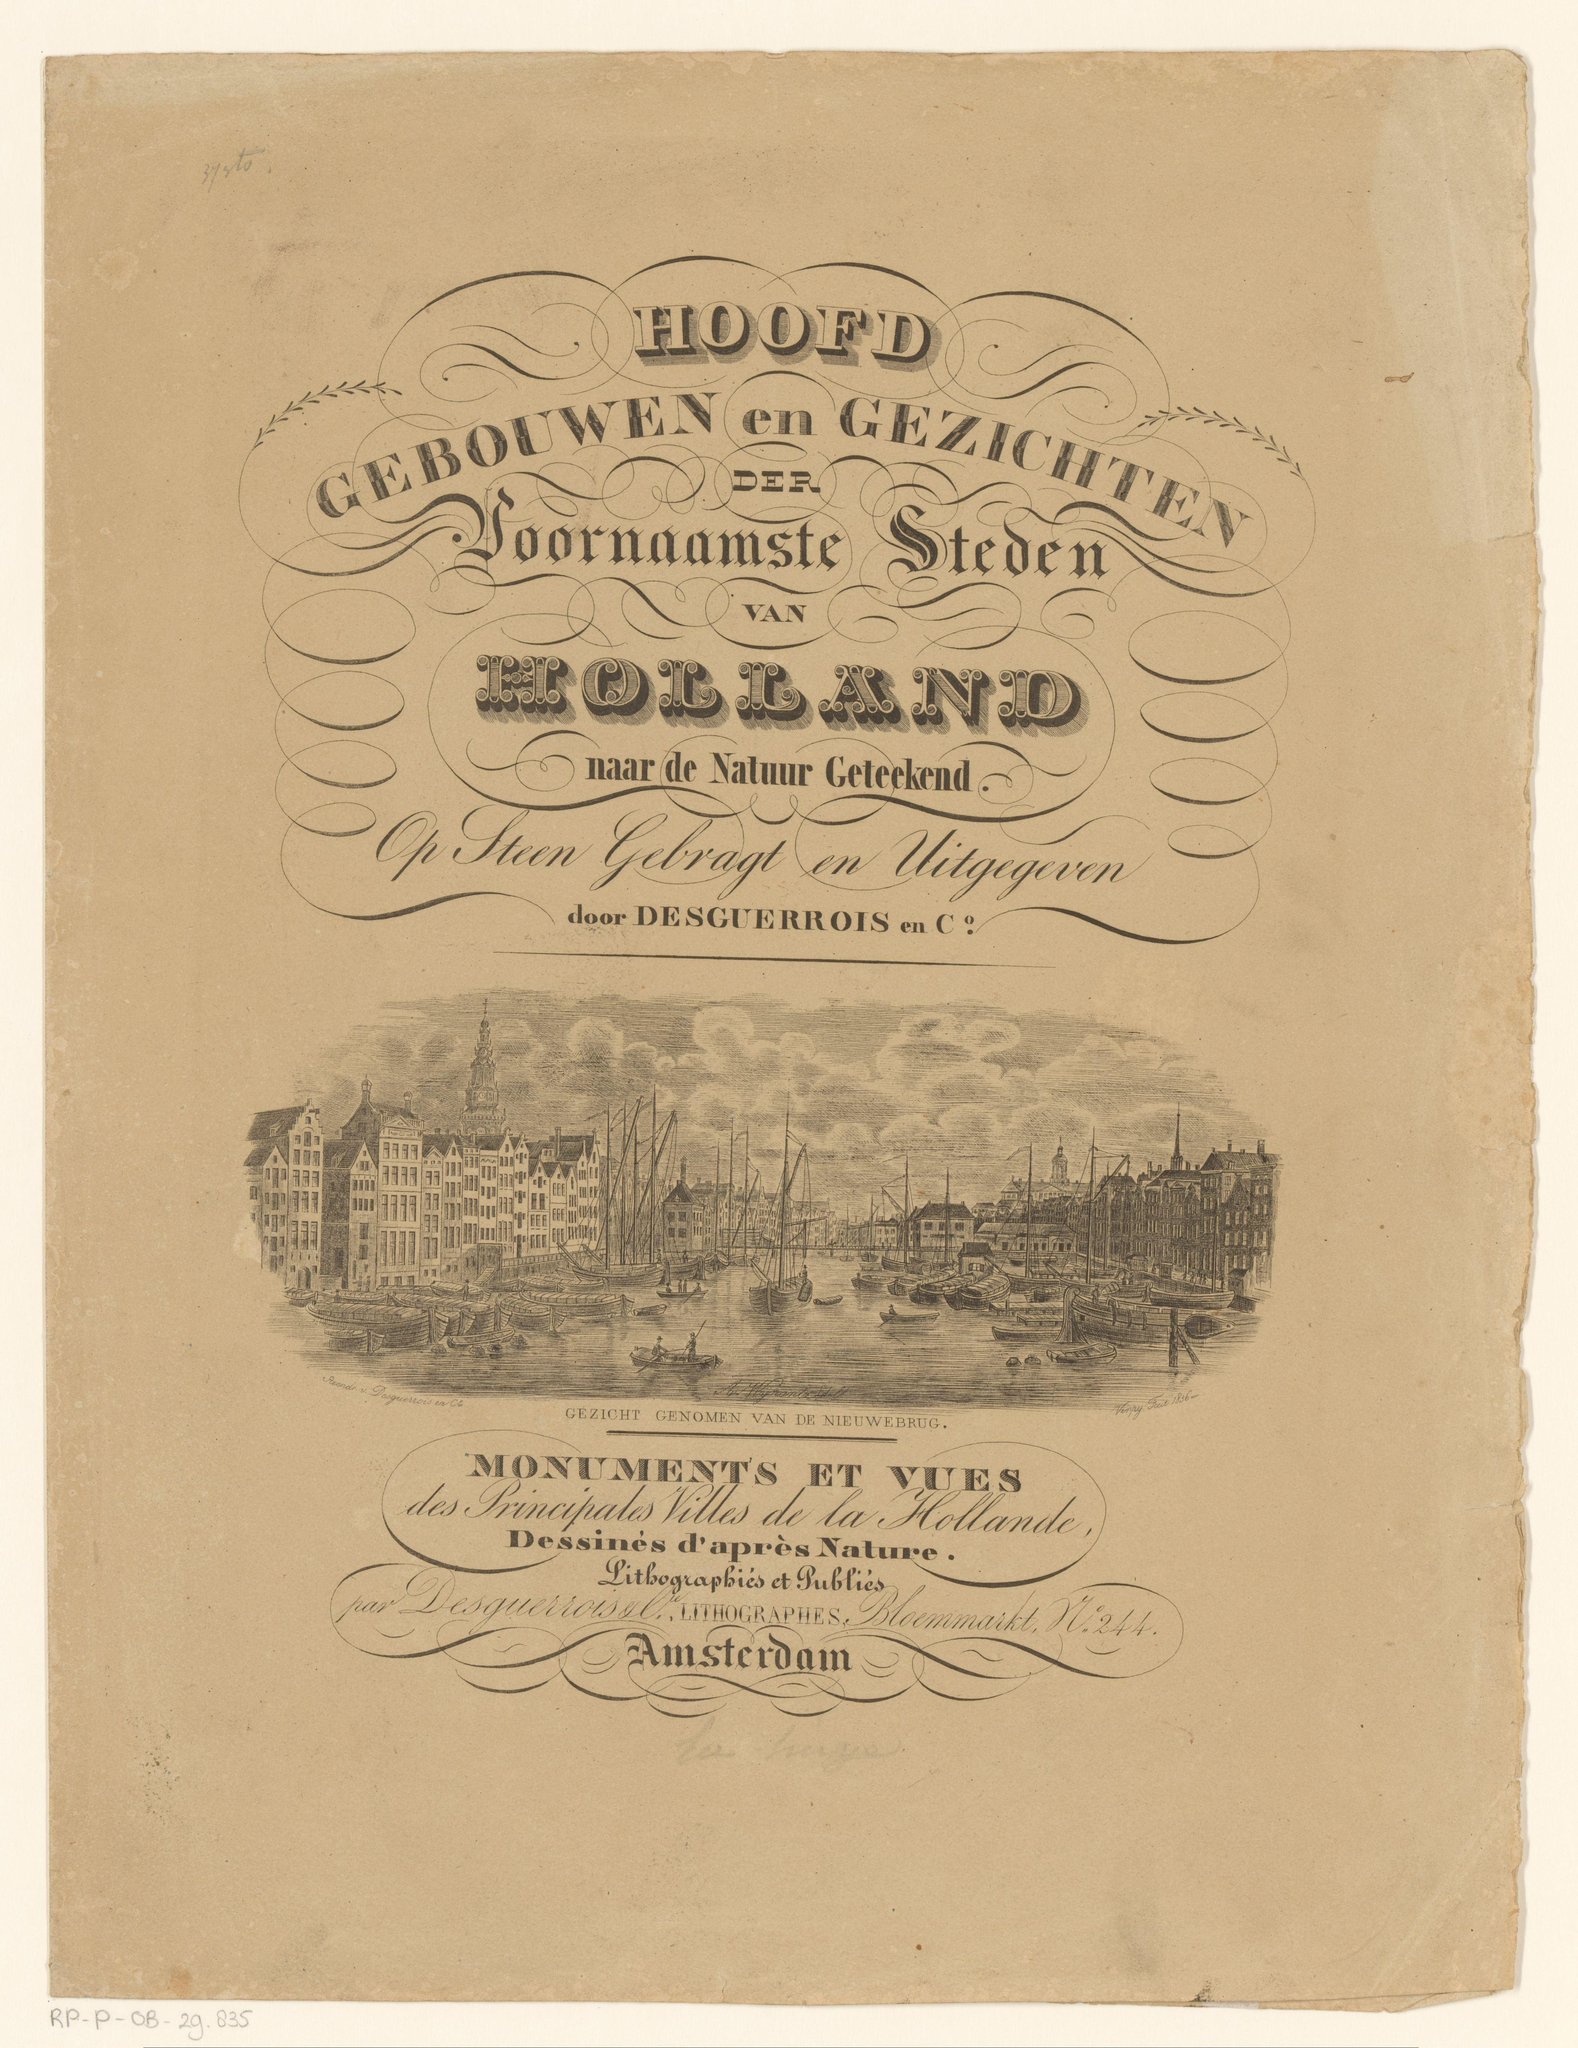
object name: wrapper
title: Gezicht genomen van de Nieuwbrug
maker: verpij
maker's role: print maker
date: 1836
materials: paper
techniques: lithograph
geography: amsterdam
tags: city-view in general; 'veduta'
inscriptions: date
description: Boten op het water te Amsterdam, gezien vanaf de Nieuwe Brug. Omslag voor een serie van gezichten in Nederlandse steden.